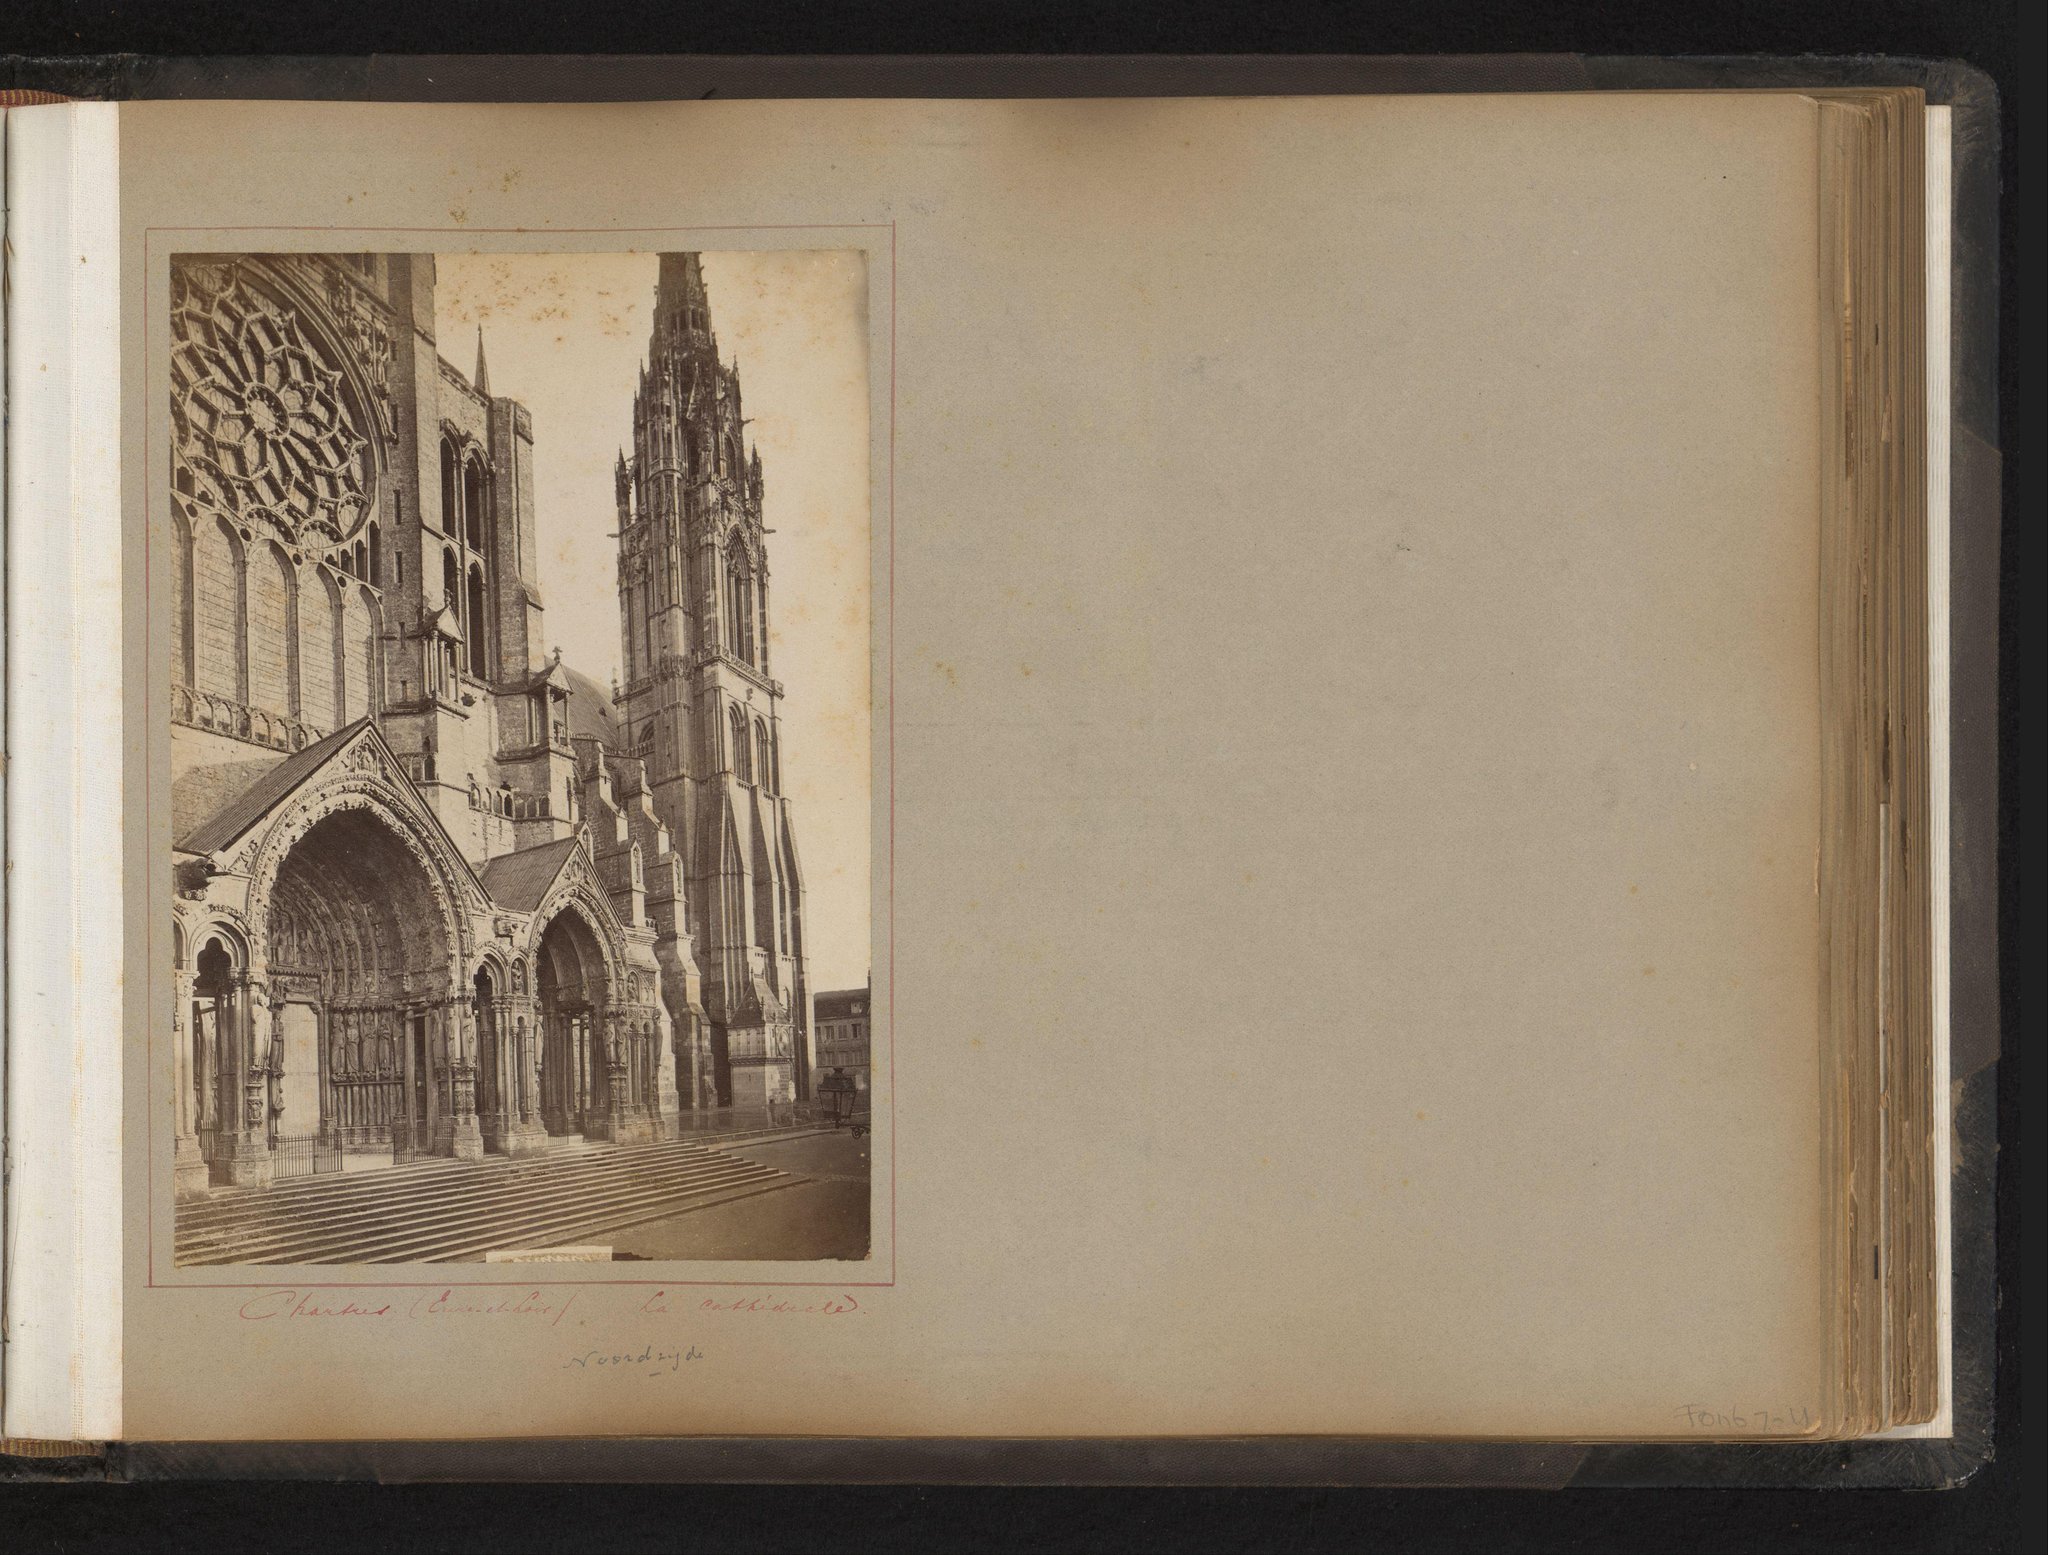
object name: album leaf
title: Kathedraal van Chartres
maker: Anonymous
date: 1880-1910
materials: photographic support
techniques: albumen print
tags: parts of church exterior and annexes: façade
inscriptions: annotation: ‘Noordzijde’, annotation: ‘Chartres (Eure-et-Loir/ La Cathédrale’